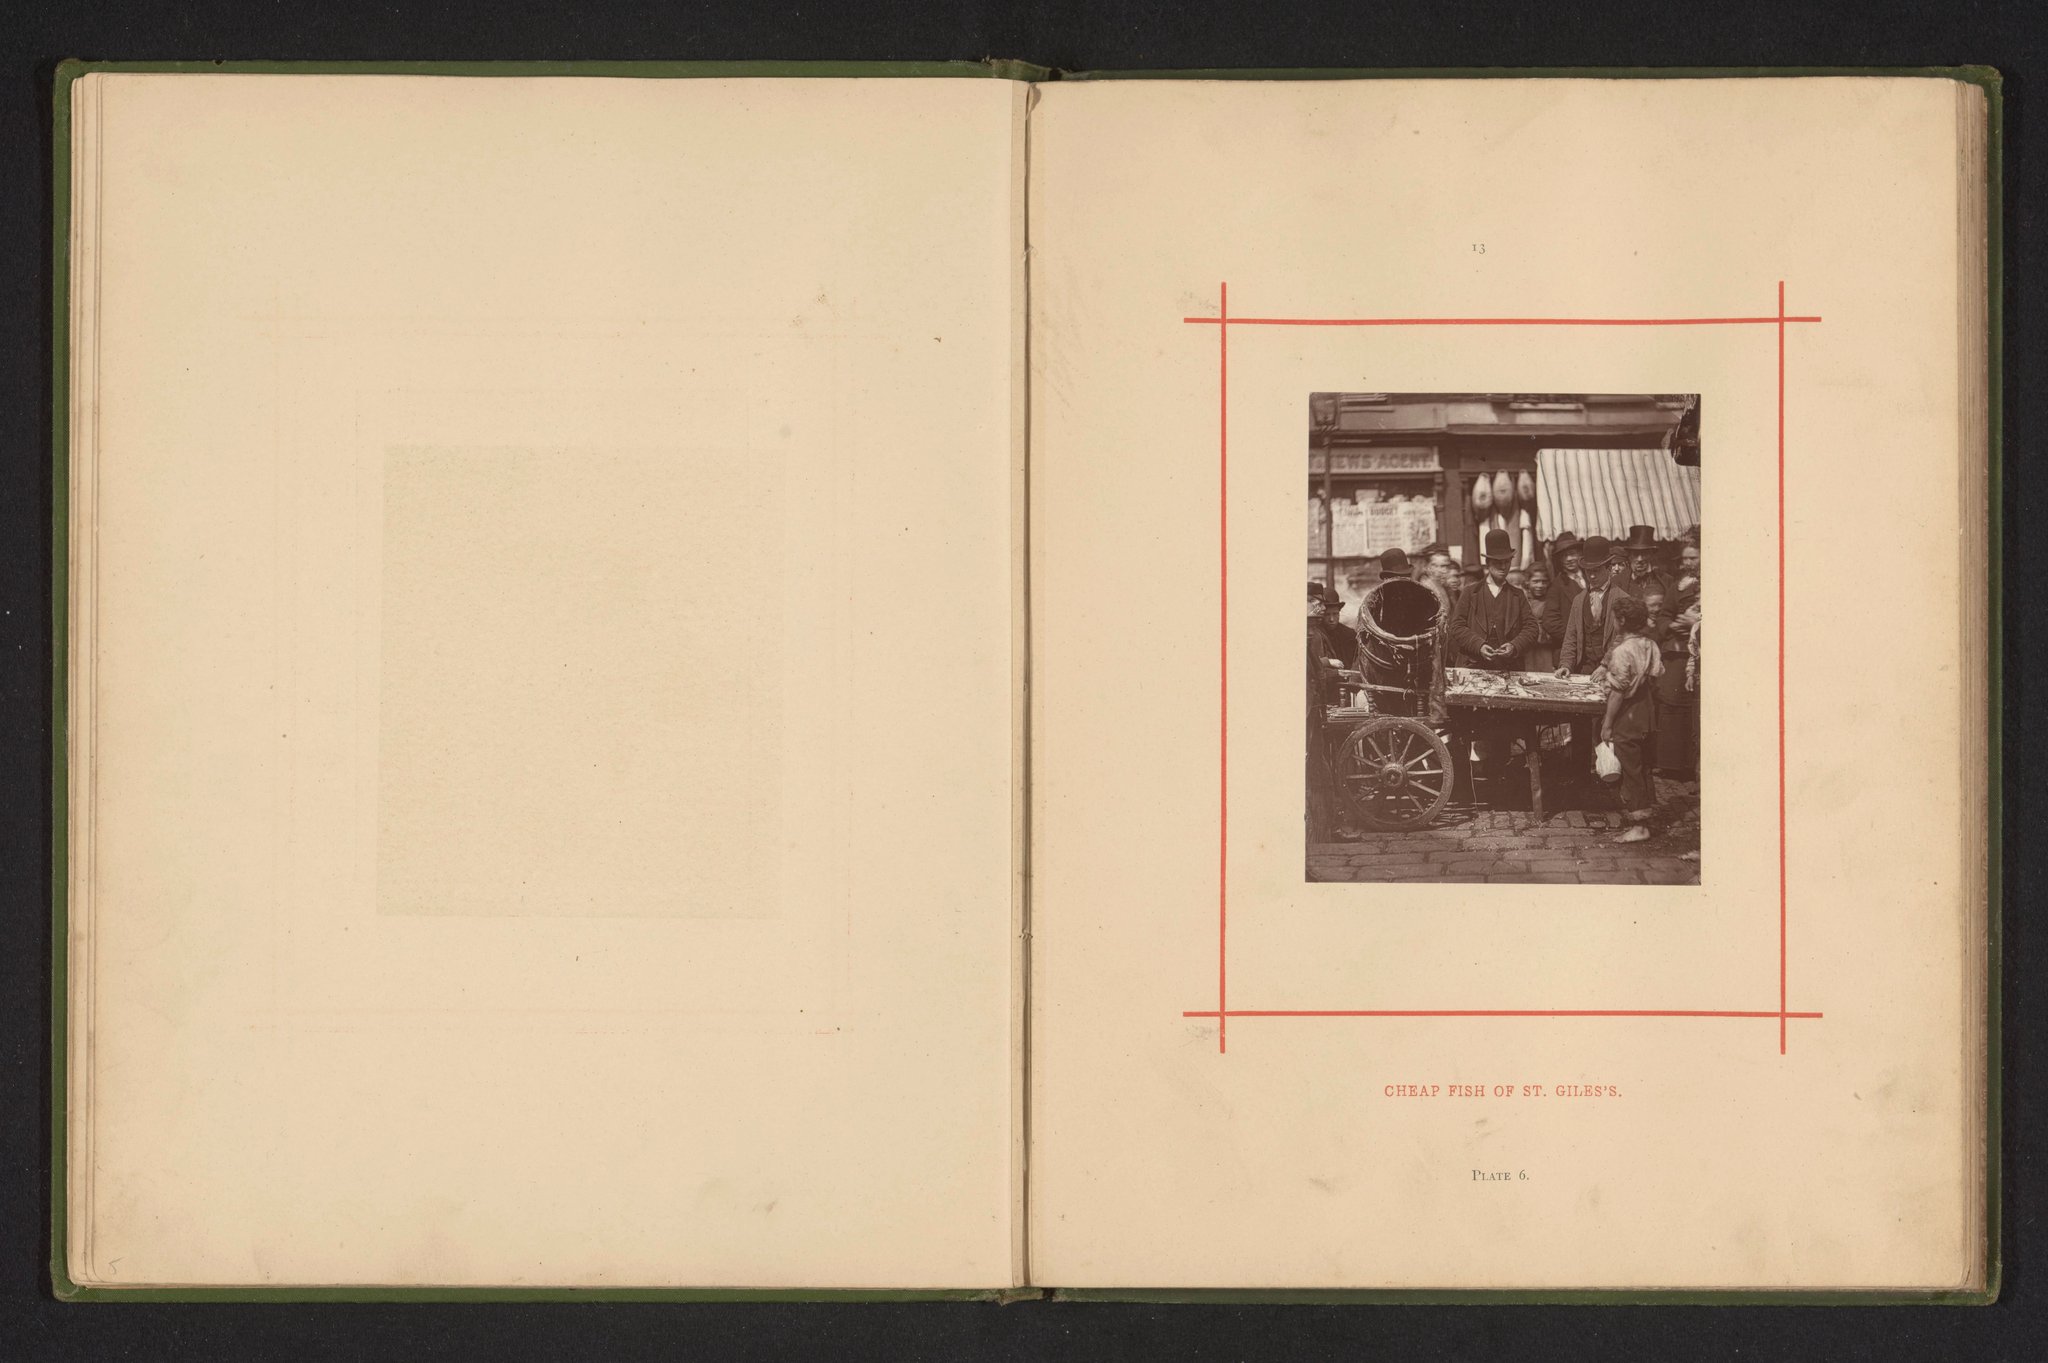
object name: photomechanical print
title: Cheap fish of St. Giles's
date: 1871-1881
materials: paper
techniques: woodburytype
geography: london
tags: fishes, persons engaged in trade and commerce, street, customer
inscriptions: number: ‘Plate 6.’